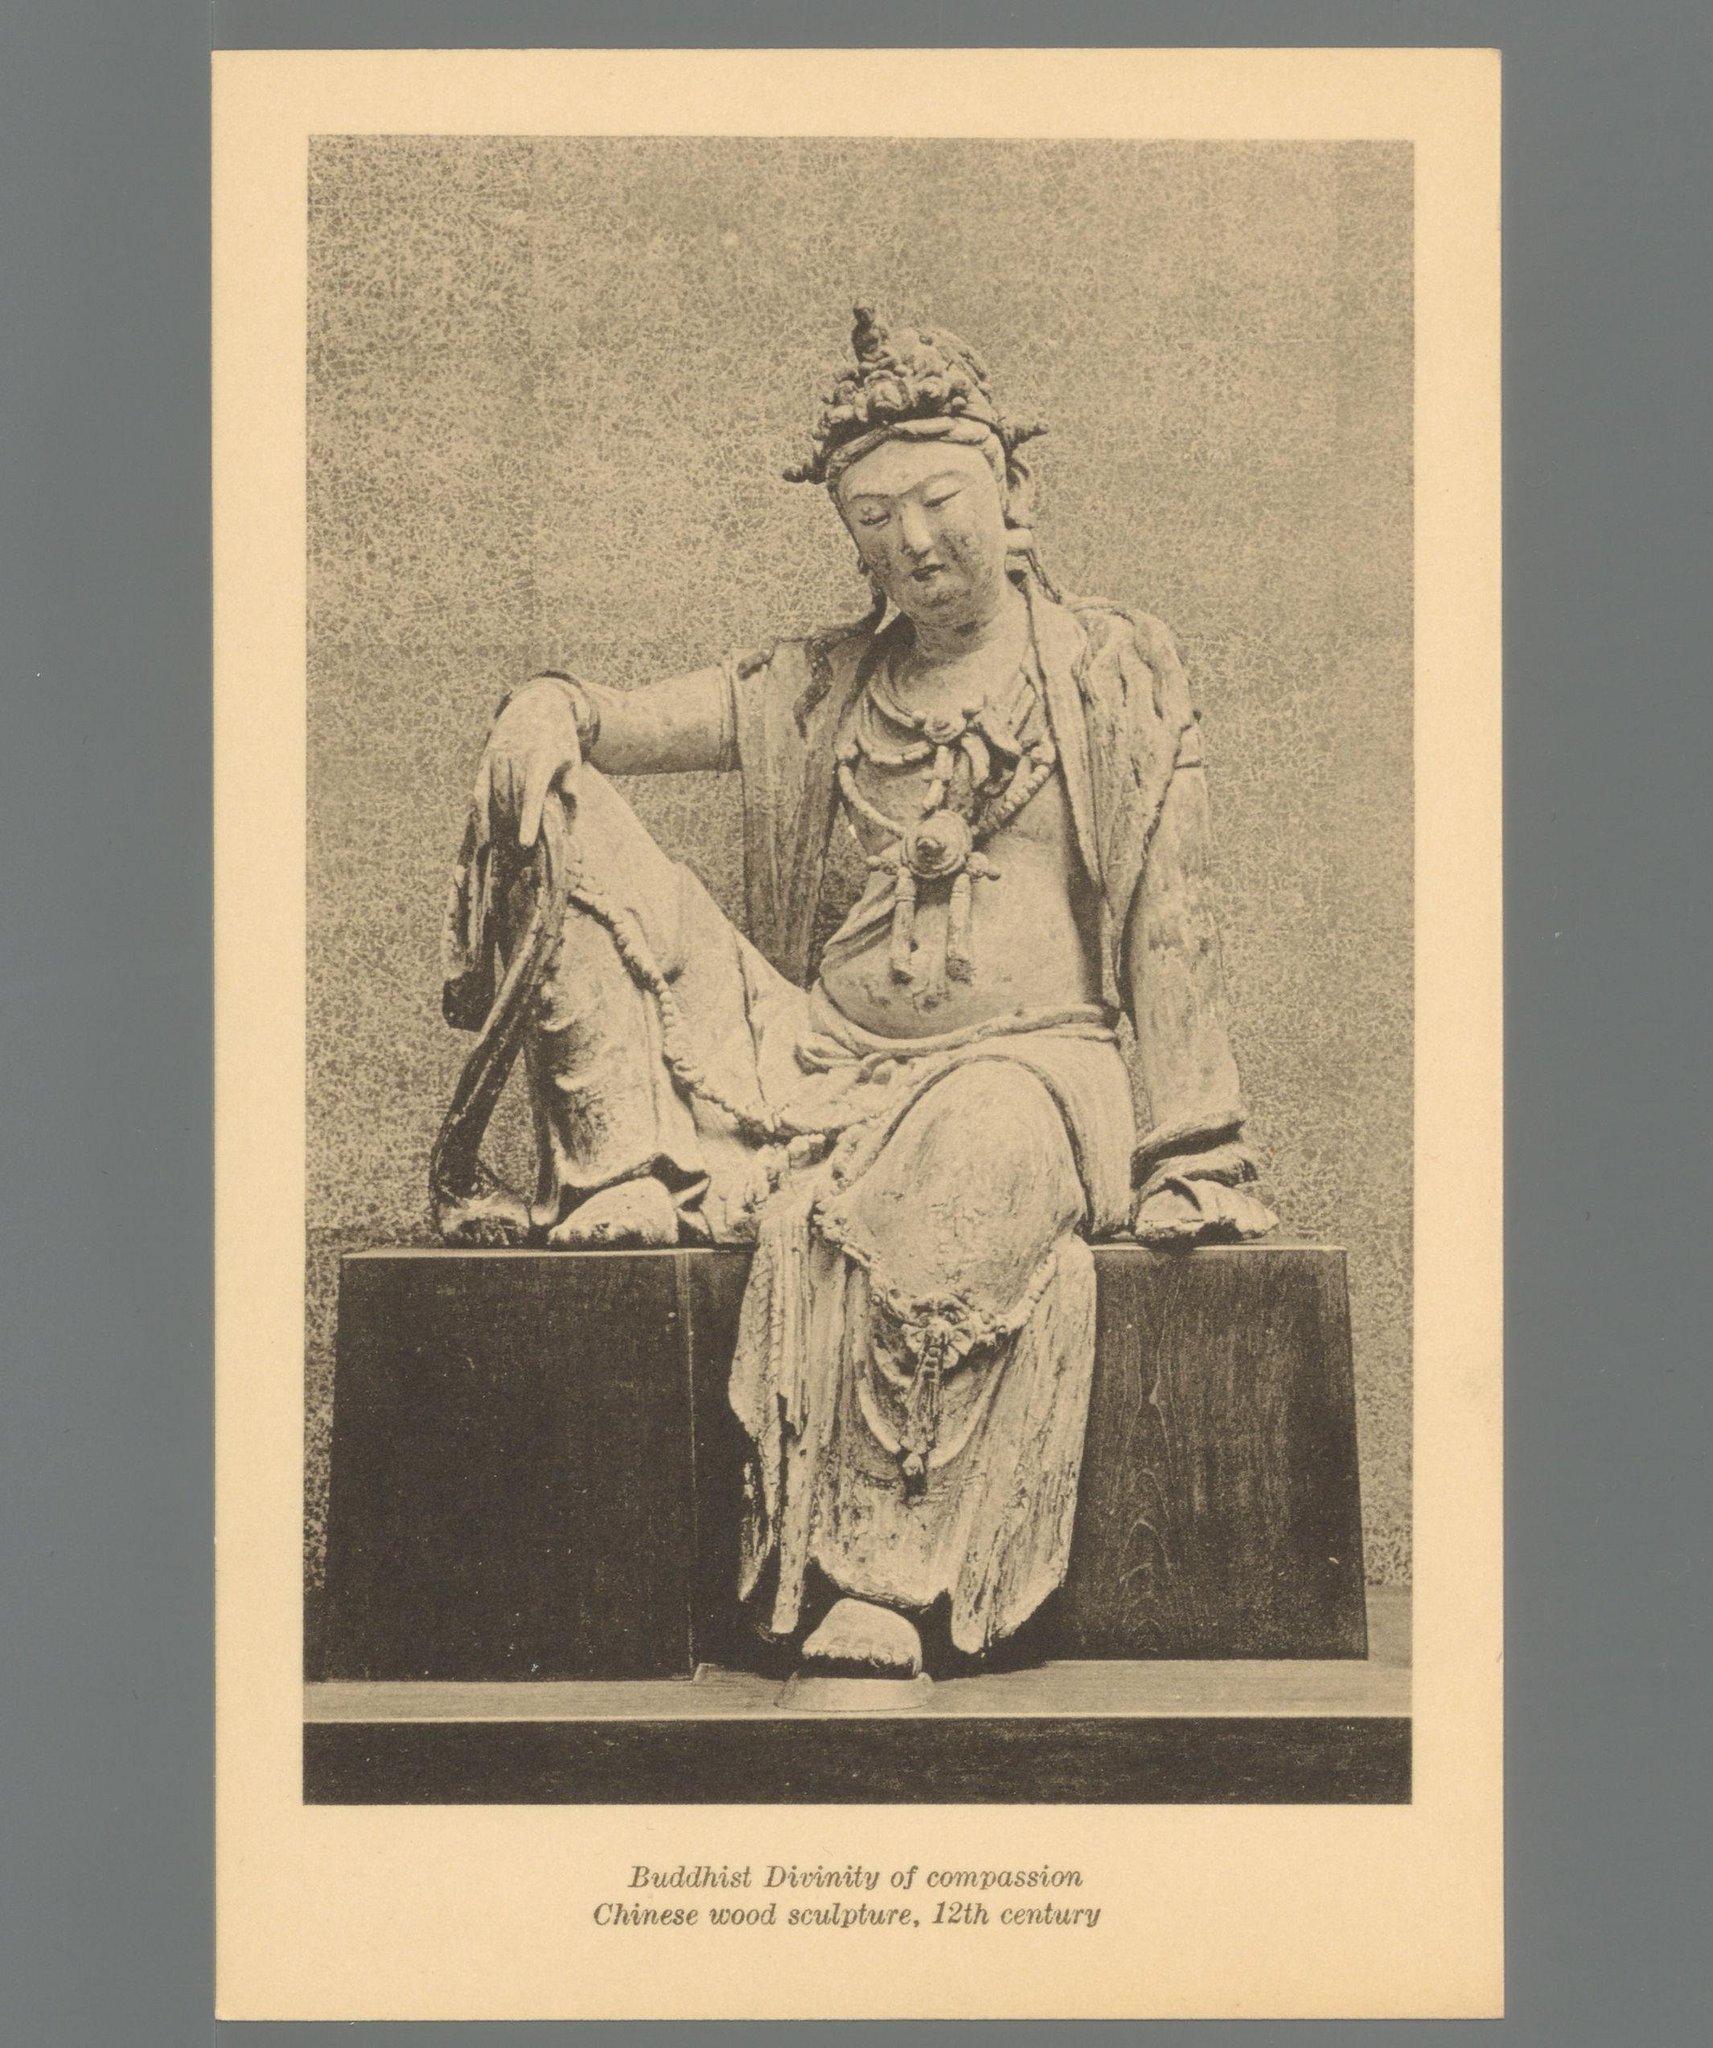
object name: photomechanical print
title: Buddhist Divinity of compassion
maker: Anonymous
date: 1920-1950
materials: cardboard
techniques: photograph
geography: oxford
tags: sculpture (+ wood, e.g.: panel ~ arts), representations ~ gods, demi-gods, heroes, etc. (hinduism, buddhism, jainism)